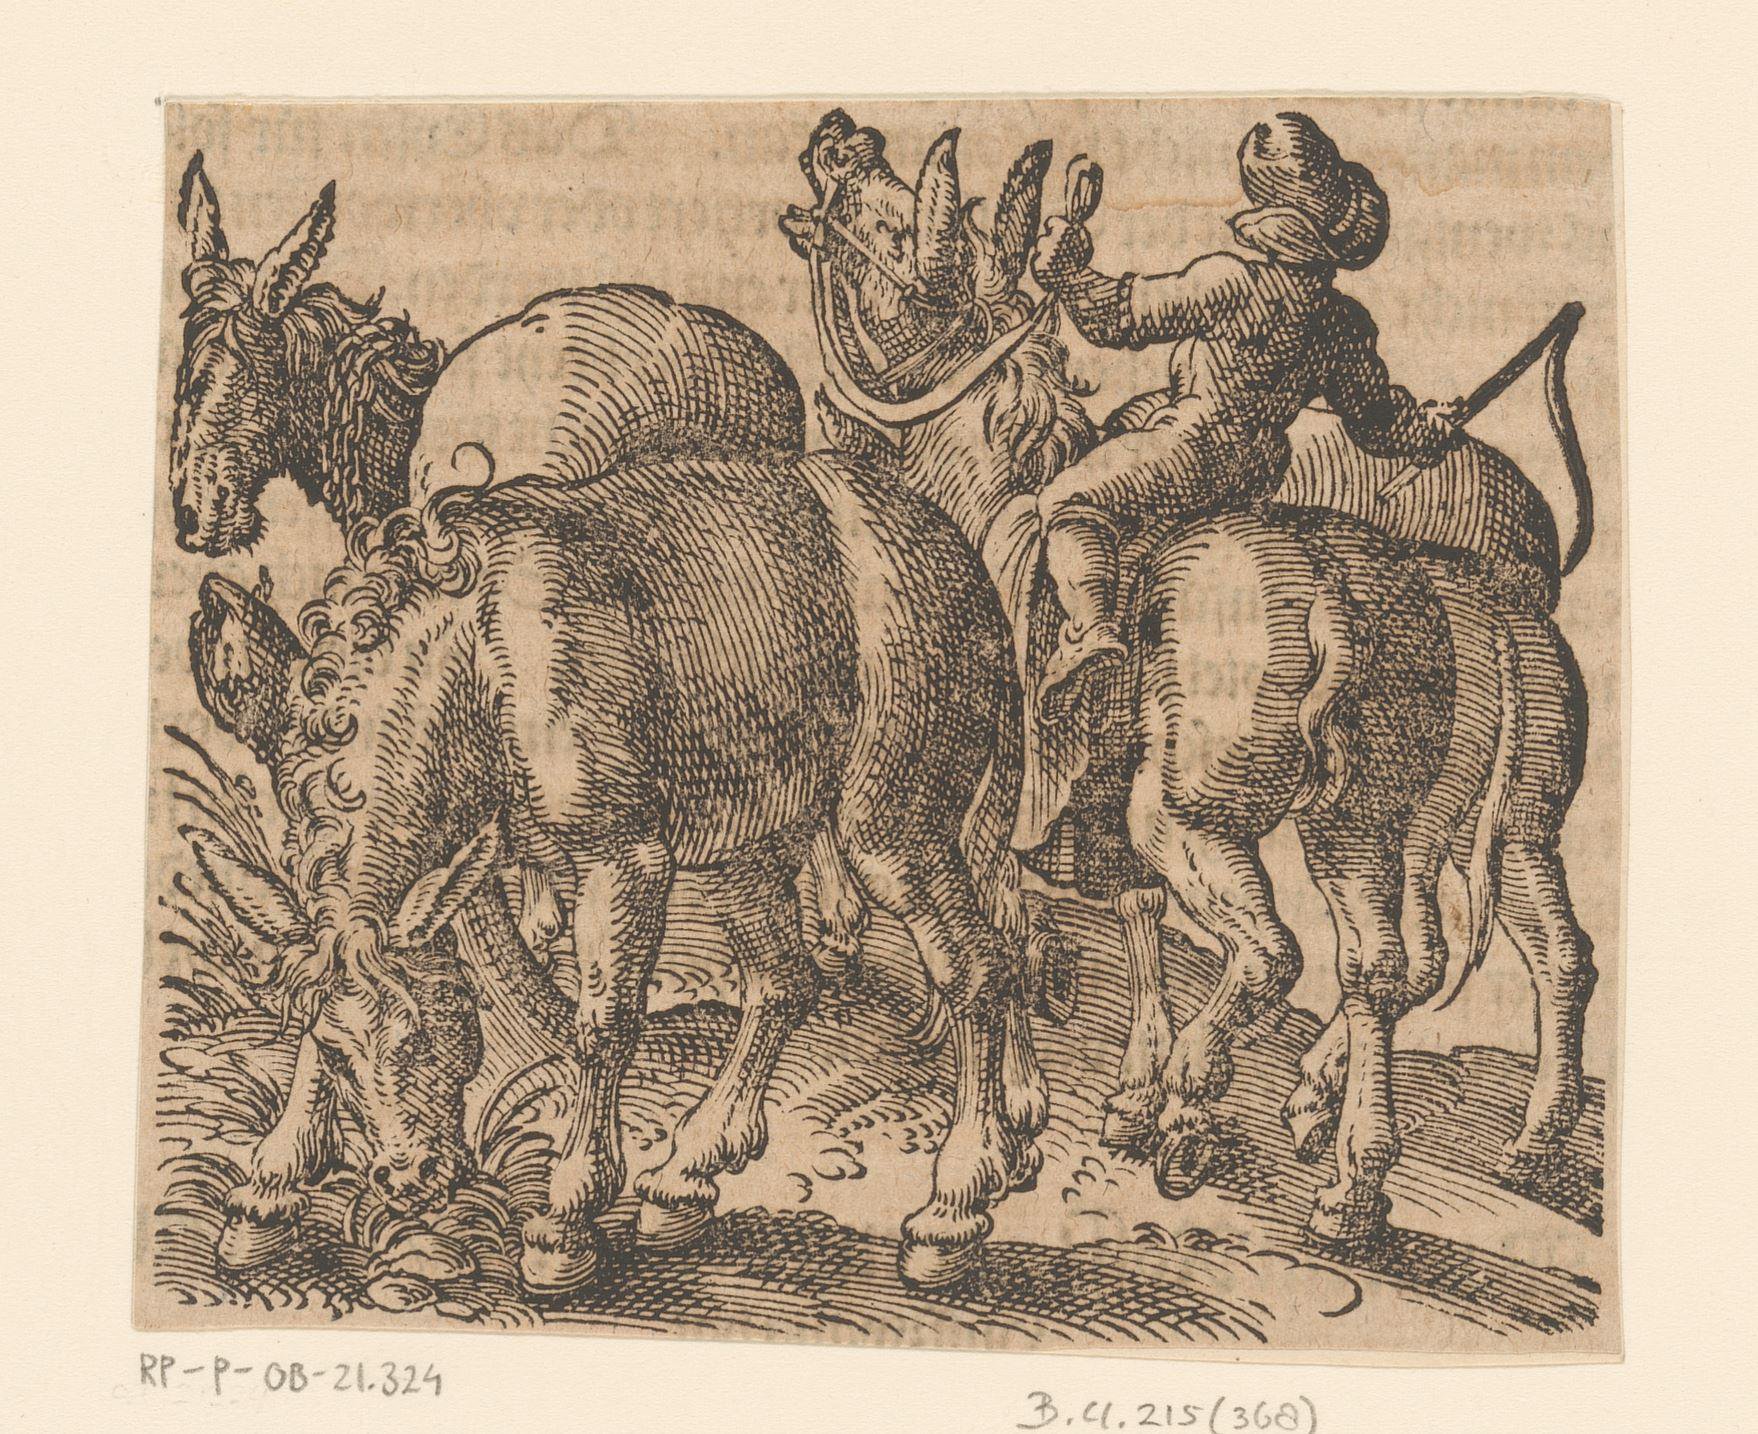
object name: print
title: Boer met vier ezels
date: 1580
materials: paper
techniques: letterpress printing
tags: riding a horse, ass, or mule; rider, horseman, ass, donkey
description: Prent gebruikt in: Amman, Jost. Kunstbüchlein. Frankfurt am Main: Feyerabend, 1580.